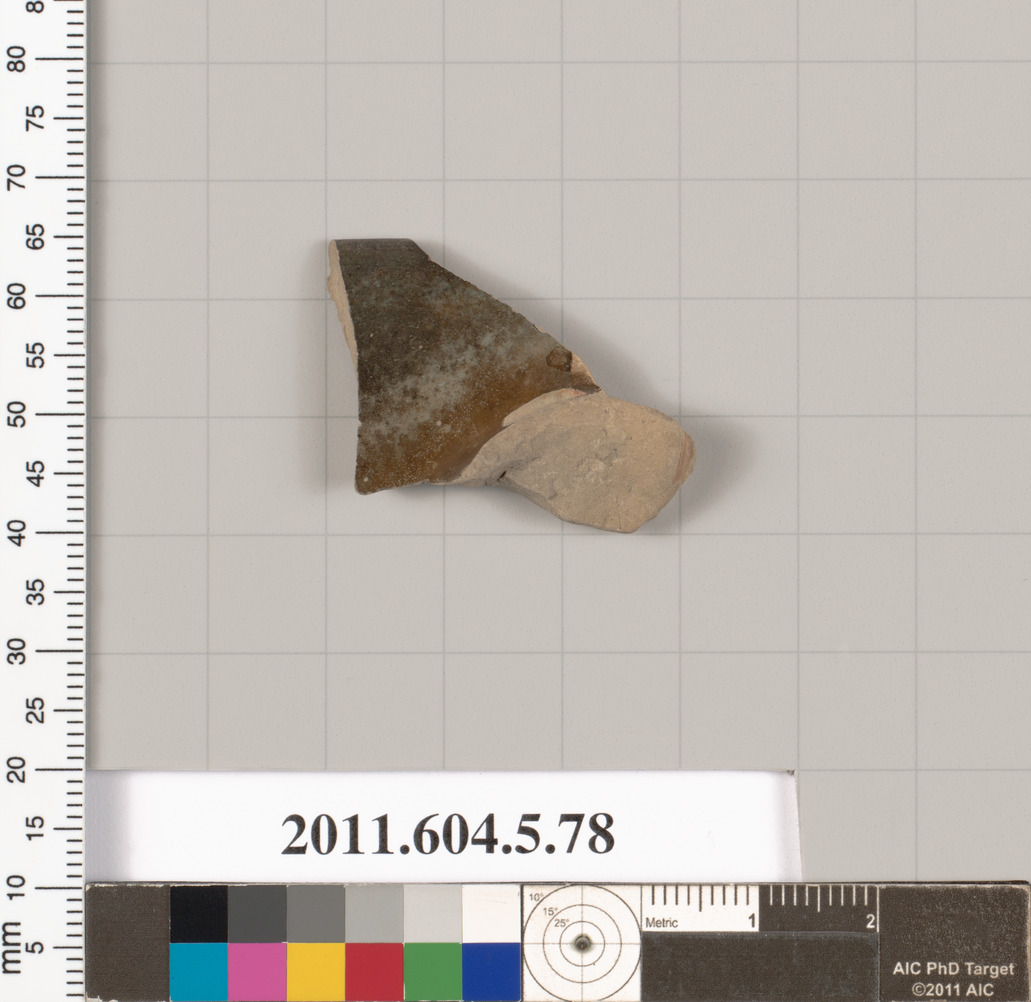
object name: kylix fragment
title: Terracotta rim fragment of a kylix (drinking cup)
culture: greek, attic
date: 500-480 BCE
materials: terracotta